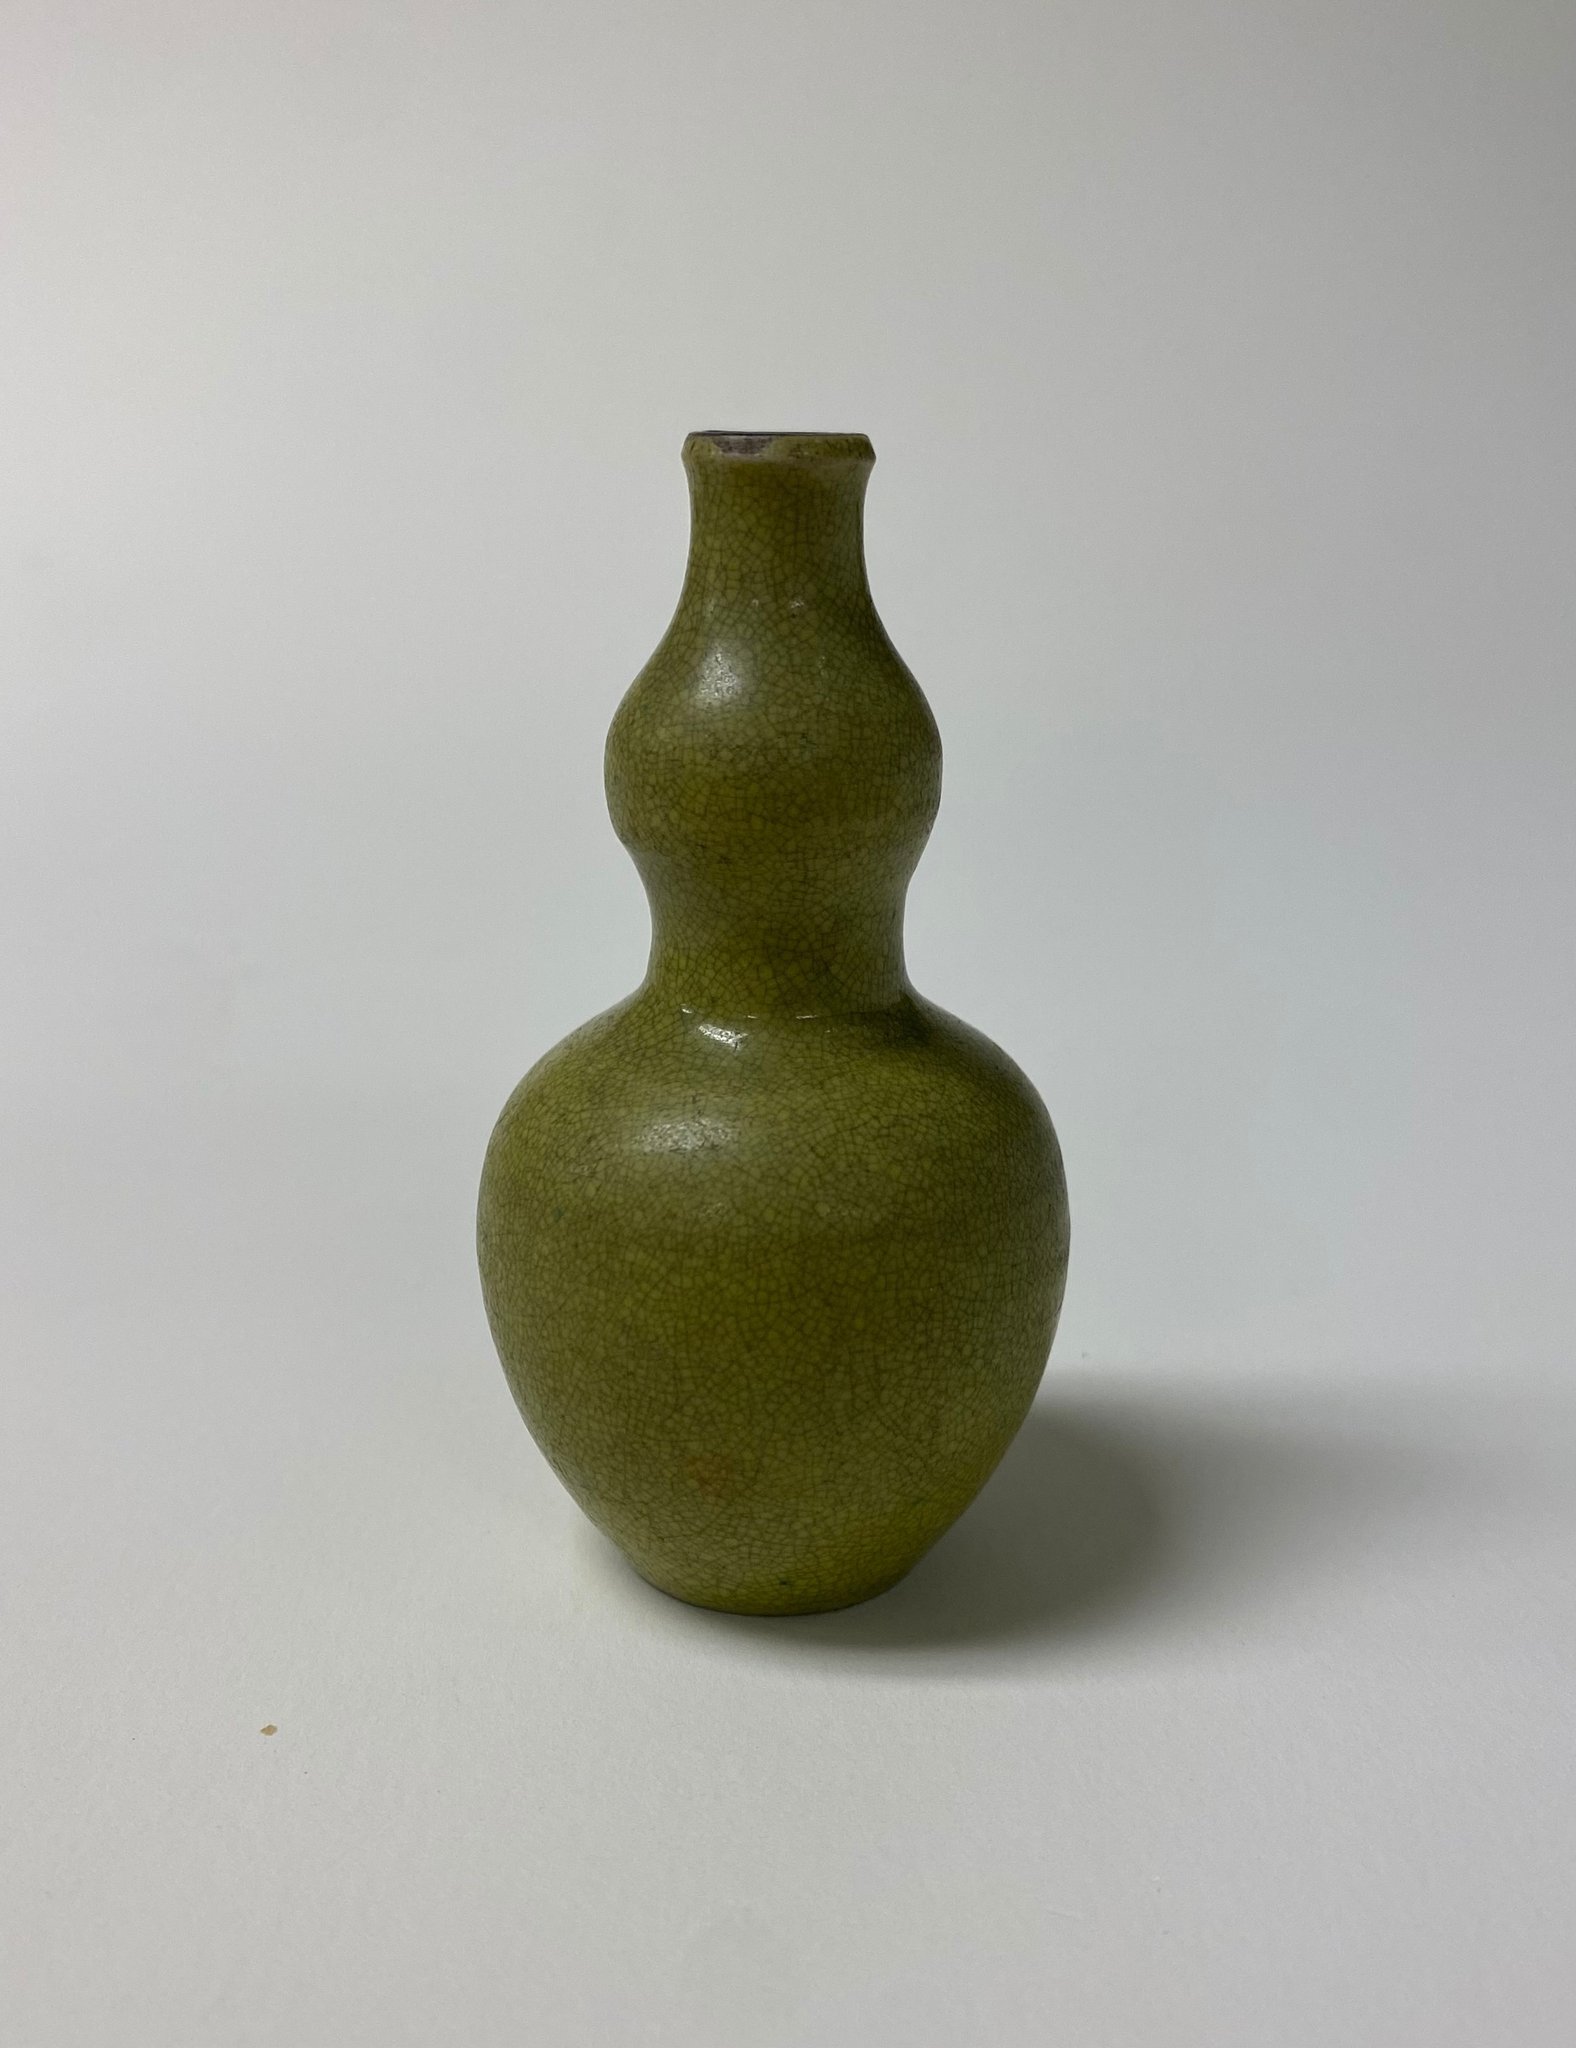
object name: vase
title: Double gourd vase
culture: chinese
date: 1801-1900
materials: glaze, porcelain